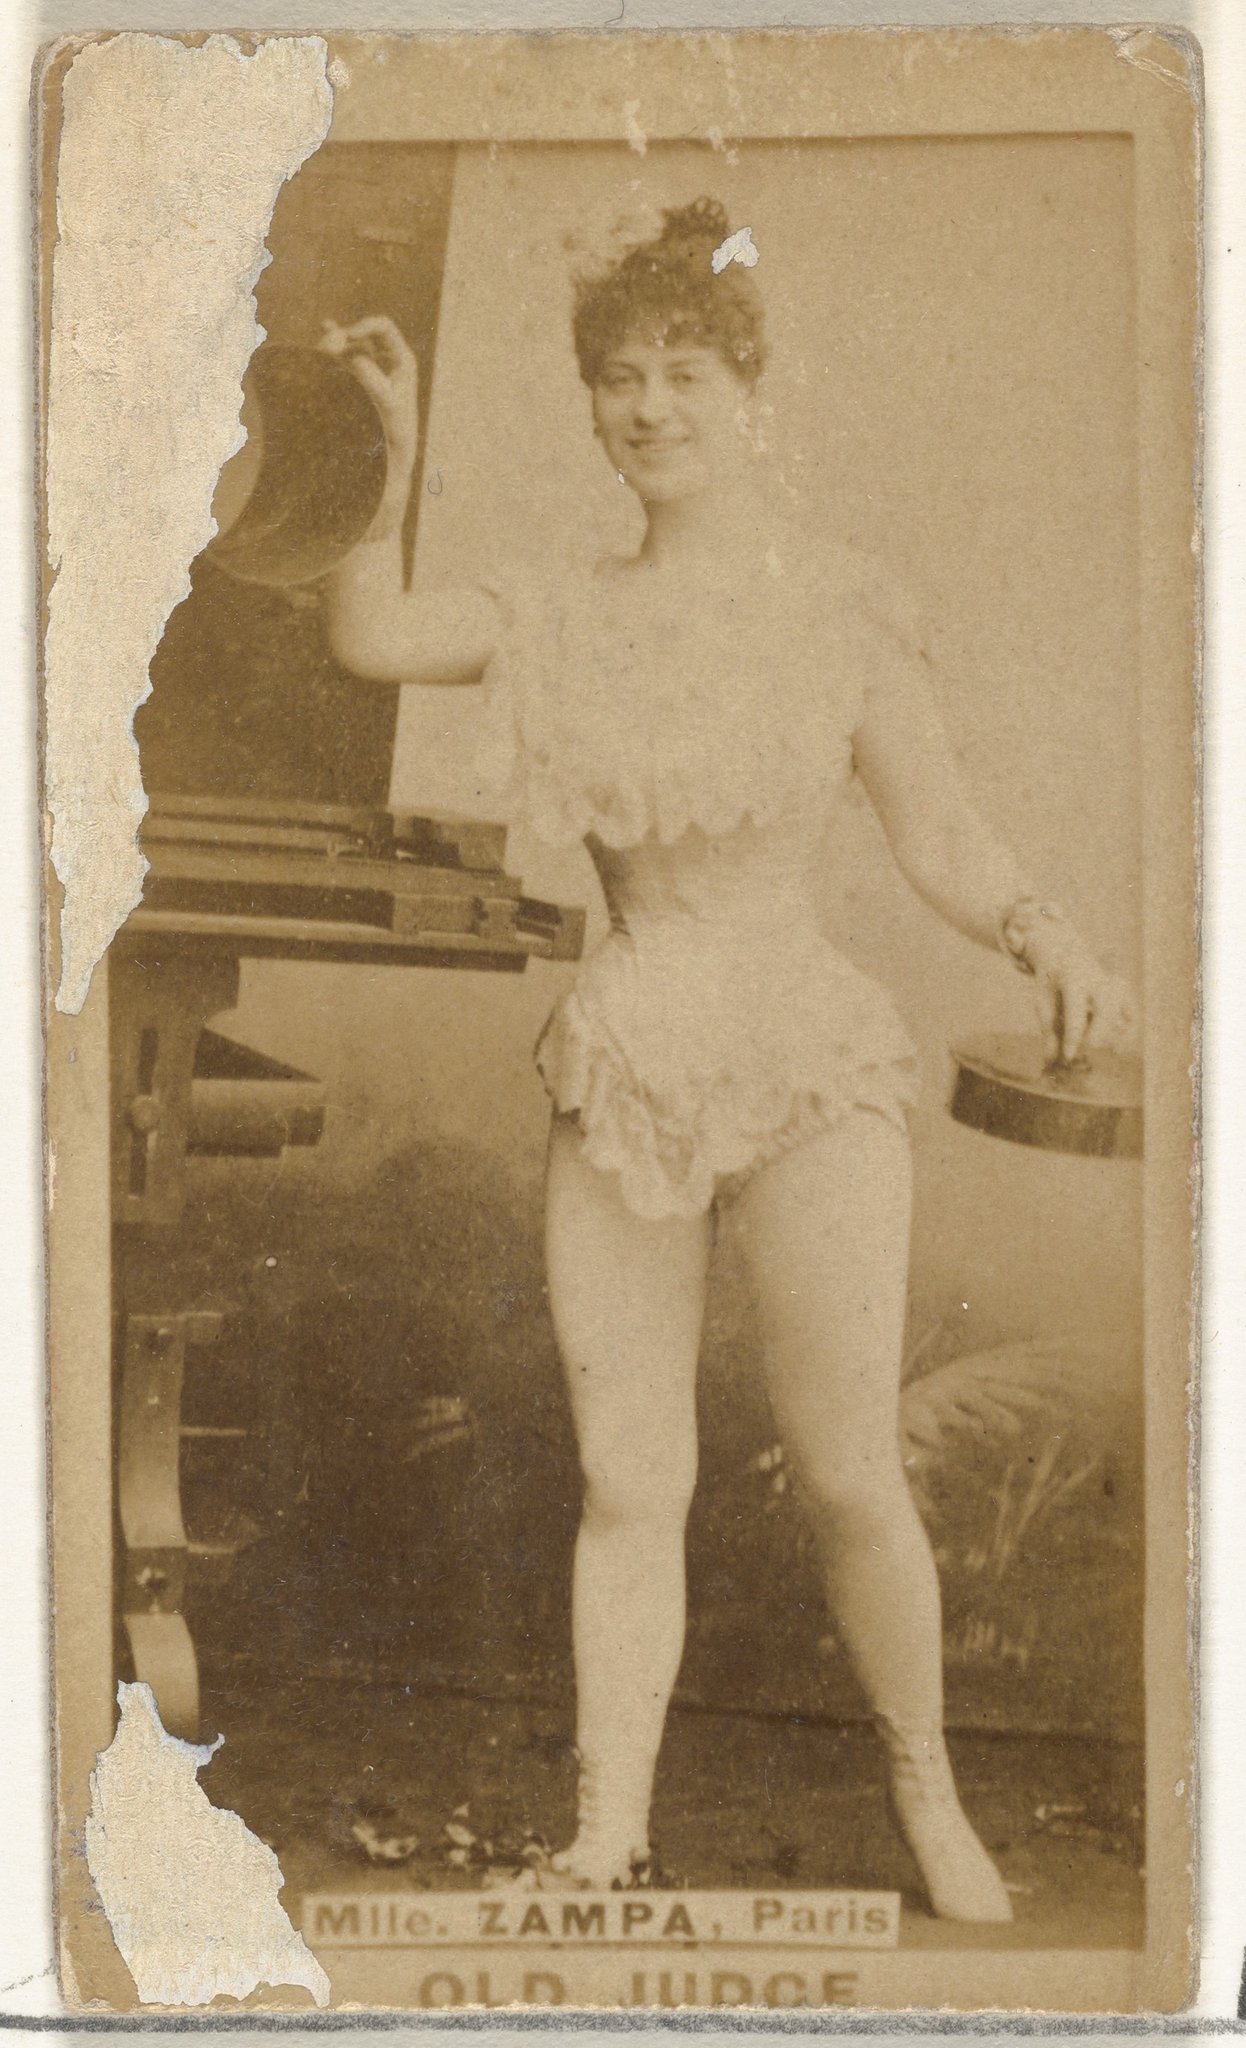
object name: photograph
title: Mlle. Zampa, Paris, from the Actors and Actresses series (N171) for Old Judge Cigarettes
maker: goodwin & company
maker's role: publisher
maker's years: 1850-1950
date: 1886-1890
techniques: albumen silver print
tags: portraits,women,actresses